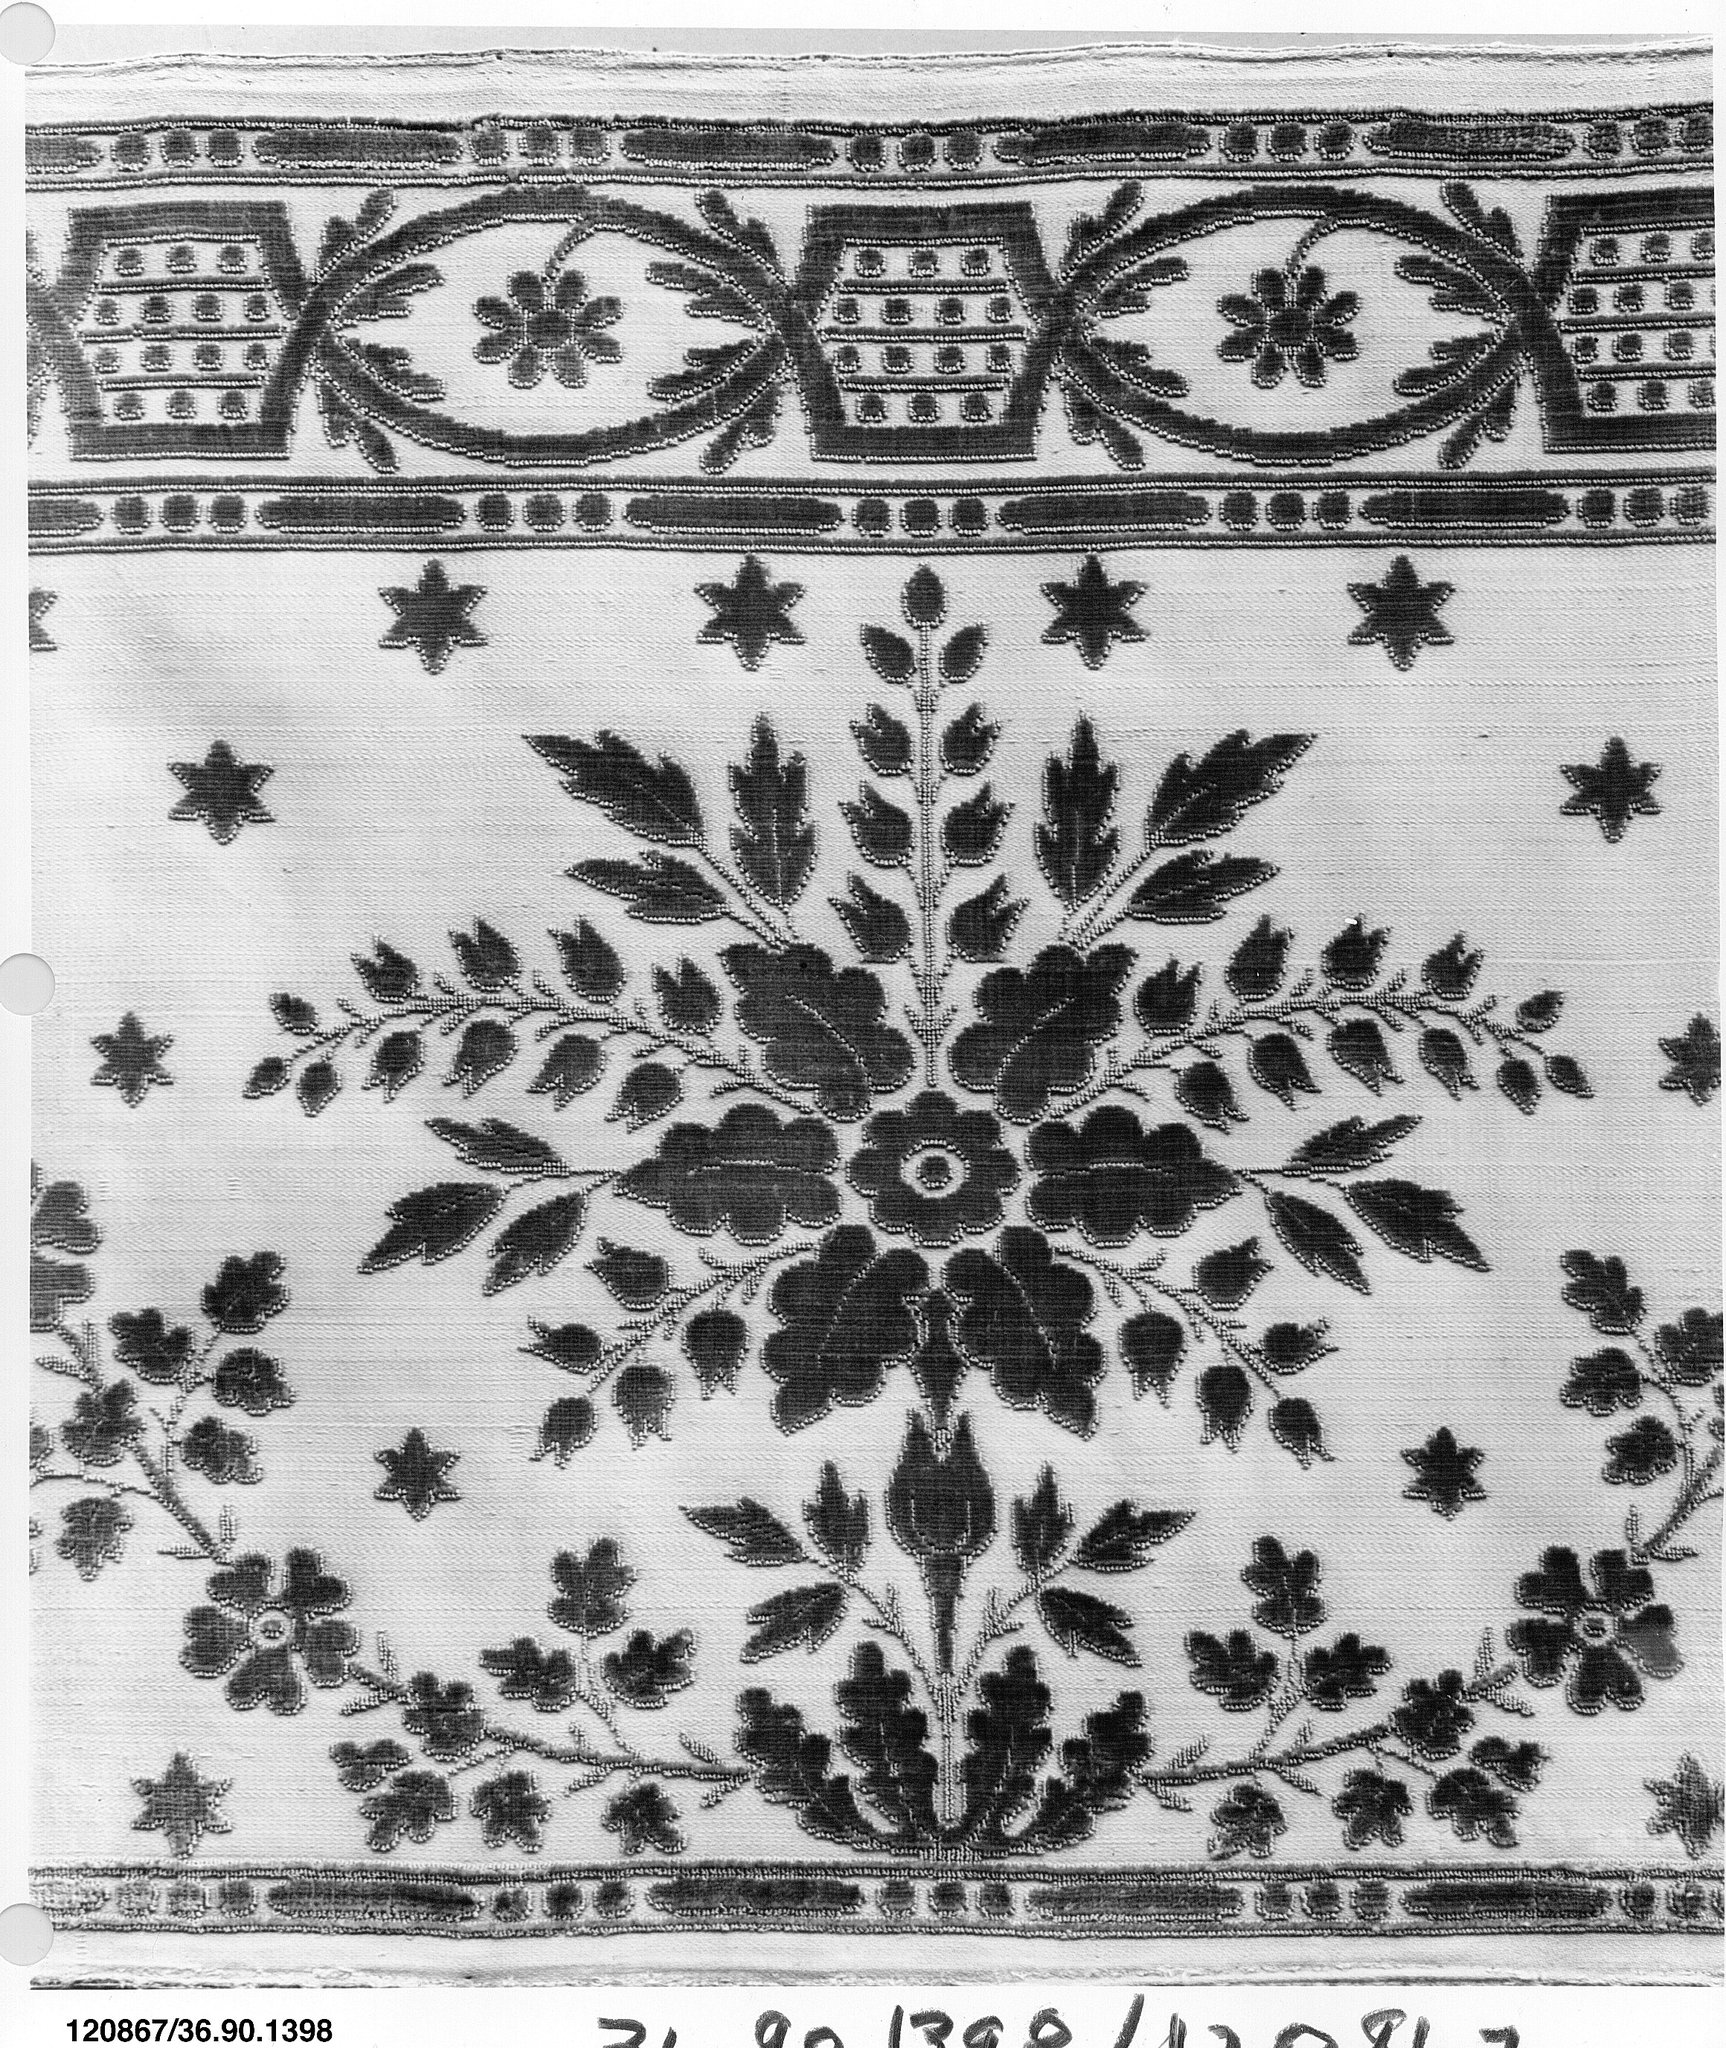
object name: piece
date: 1701-1800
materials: silk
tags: flowers,leaves